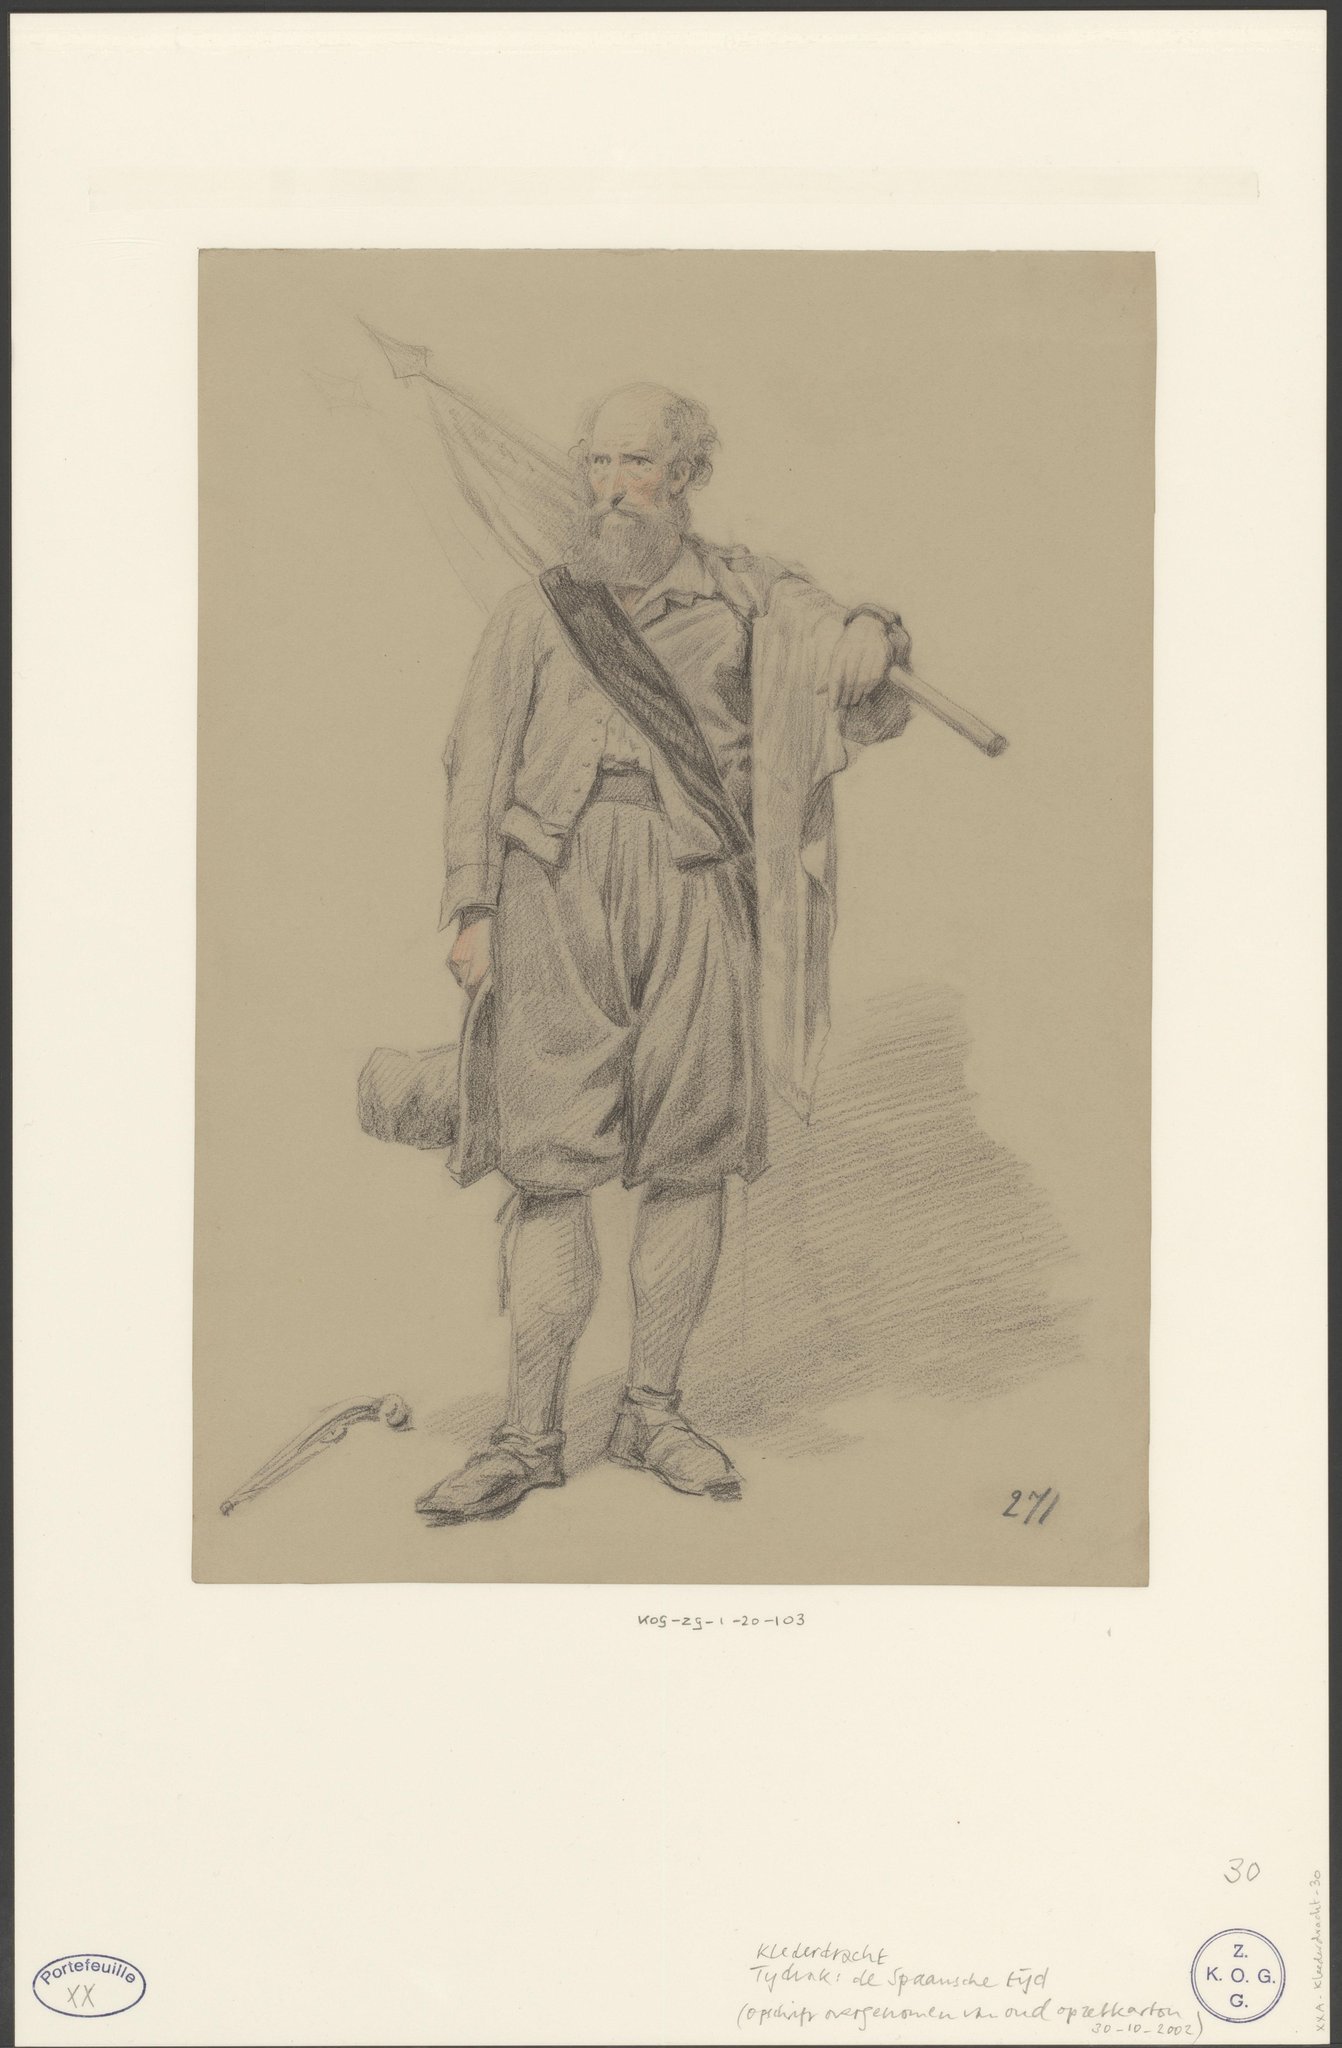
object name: drawing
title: Man met vaandel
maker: Anonymous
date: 1800-1899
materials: chalk, paper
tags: standard-bearer, flag-bearer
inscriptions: collector's mark: Lugt 1641, stamp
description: Rechtsonder genummerd: 271. Op verso een deel van dezelfde tekening. Onderwerpsrubrieken binnen de Atlas Zeden en Gewoonten: Zeden en Gewoonten in Engeren Zin, De Kleeding, Kleederdrachten (tijdvakken), De Spaansche tijd. (1550 – 1600).